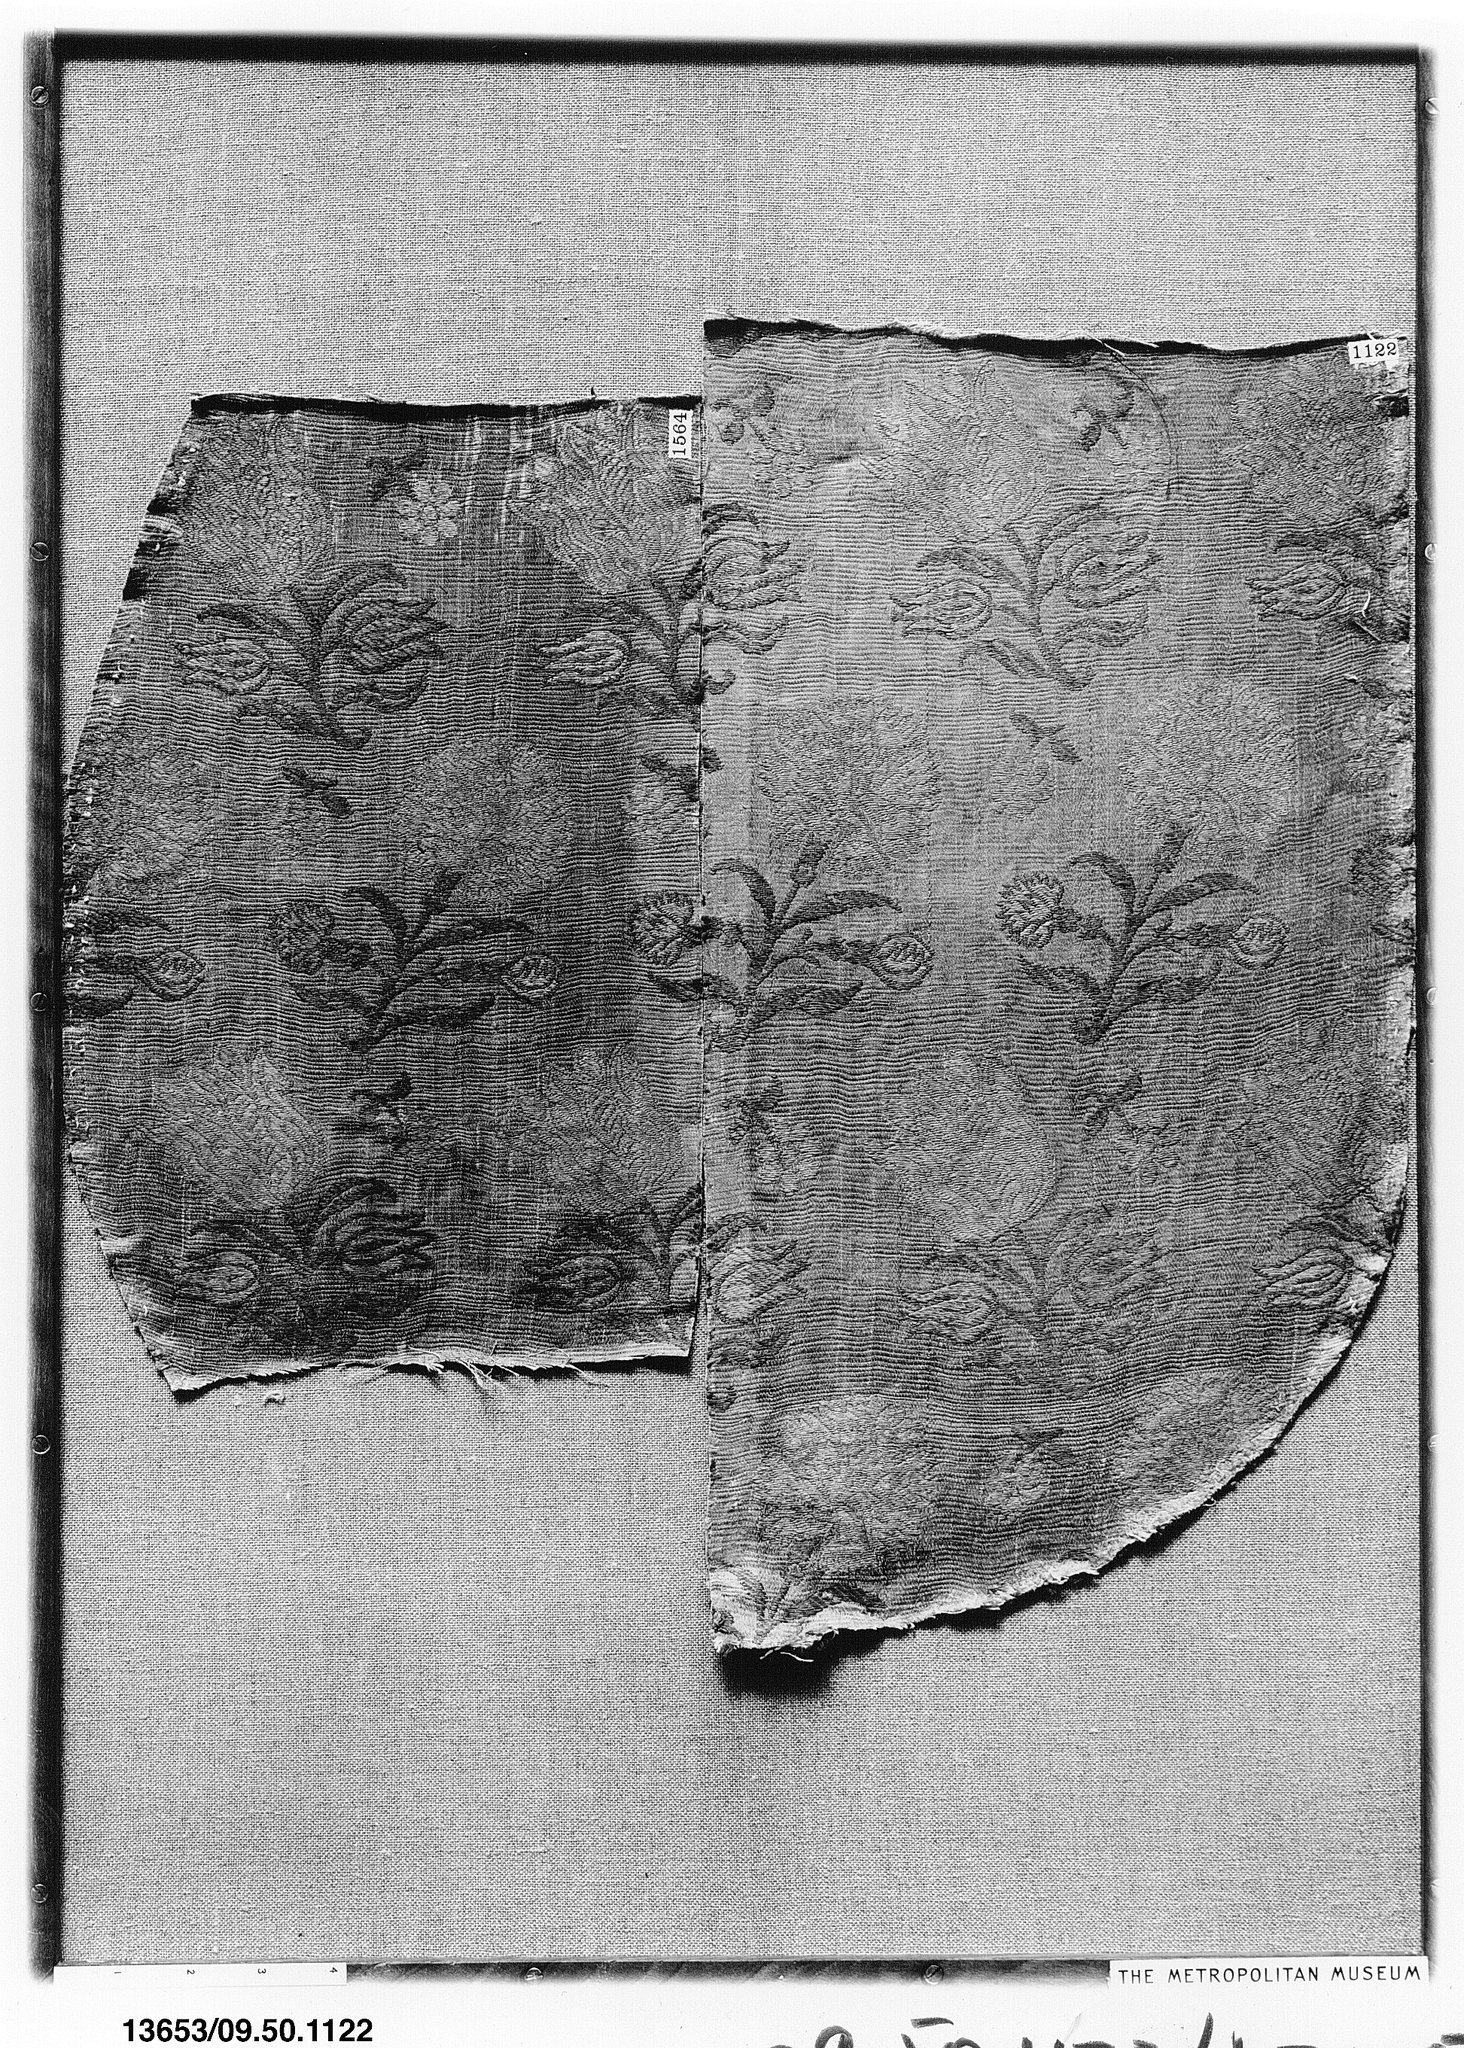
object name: piece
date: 1701-1800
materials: silk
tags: flowers,leaves